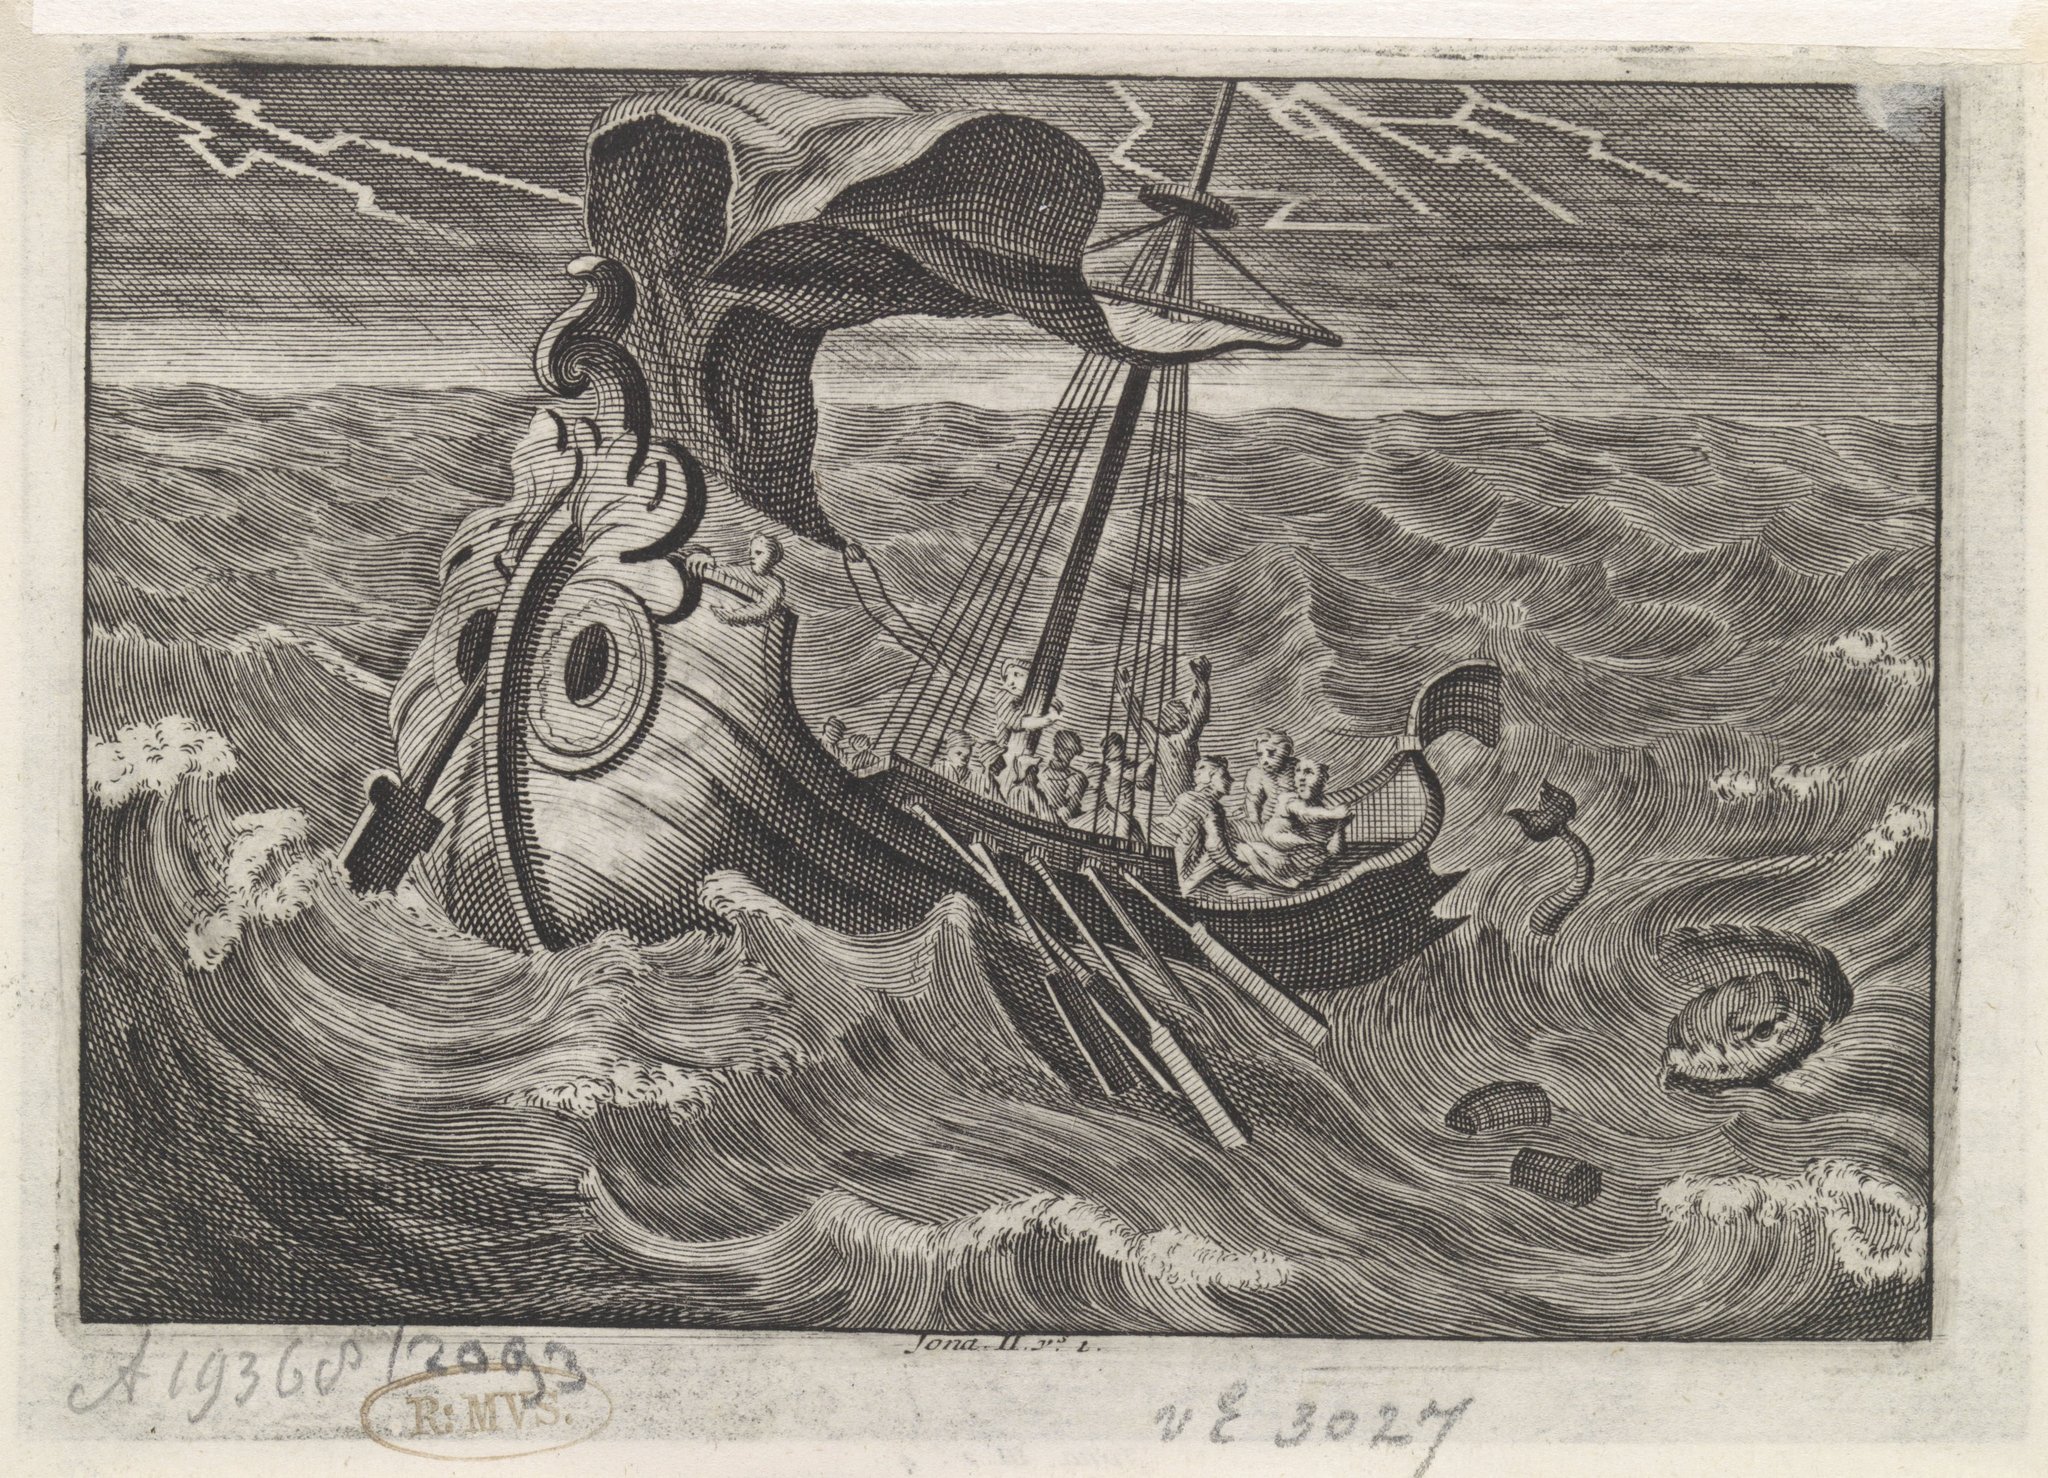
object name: book illustration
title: Jona wordt door de vissers overboord gegooid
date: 1703-1762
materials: paper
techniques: etching, letterpress printing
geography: haarlem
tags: the sailors reluctantly throw the prophet jonah into the sea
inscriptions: collector's mark: Lugt 2228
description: De prent op het verso komt een eerste keer voor als boekillustratie voor David Martin. Historie des Ouden en Nieuwen Testaments. Amsterdam, Pieter Mortier, 1703. Deel I. De boekillustraties voor de Mortierbijbel hebben verschillende staten en kopieën, waarbij de chronologische volgorde moeilijk te achterhalen valt. Als boekillustraties werden ze bovendien herhaaldelijk opnieuw gebruikt voor andere boekwerken.